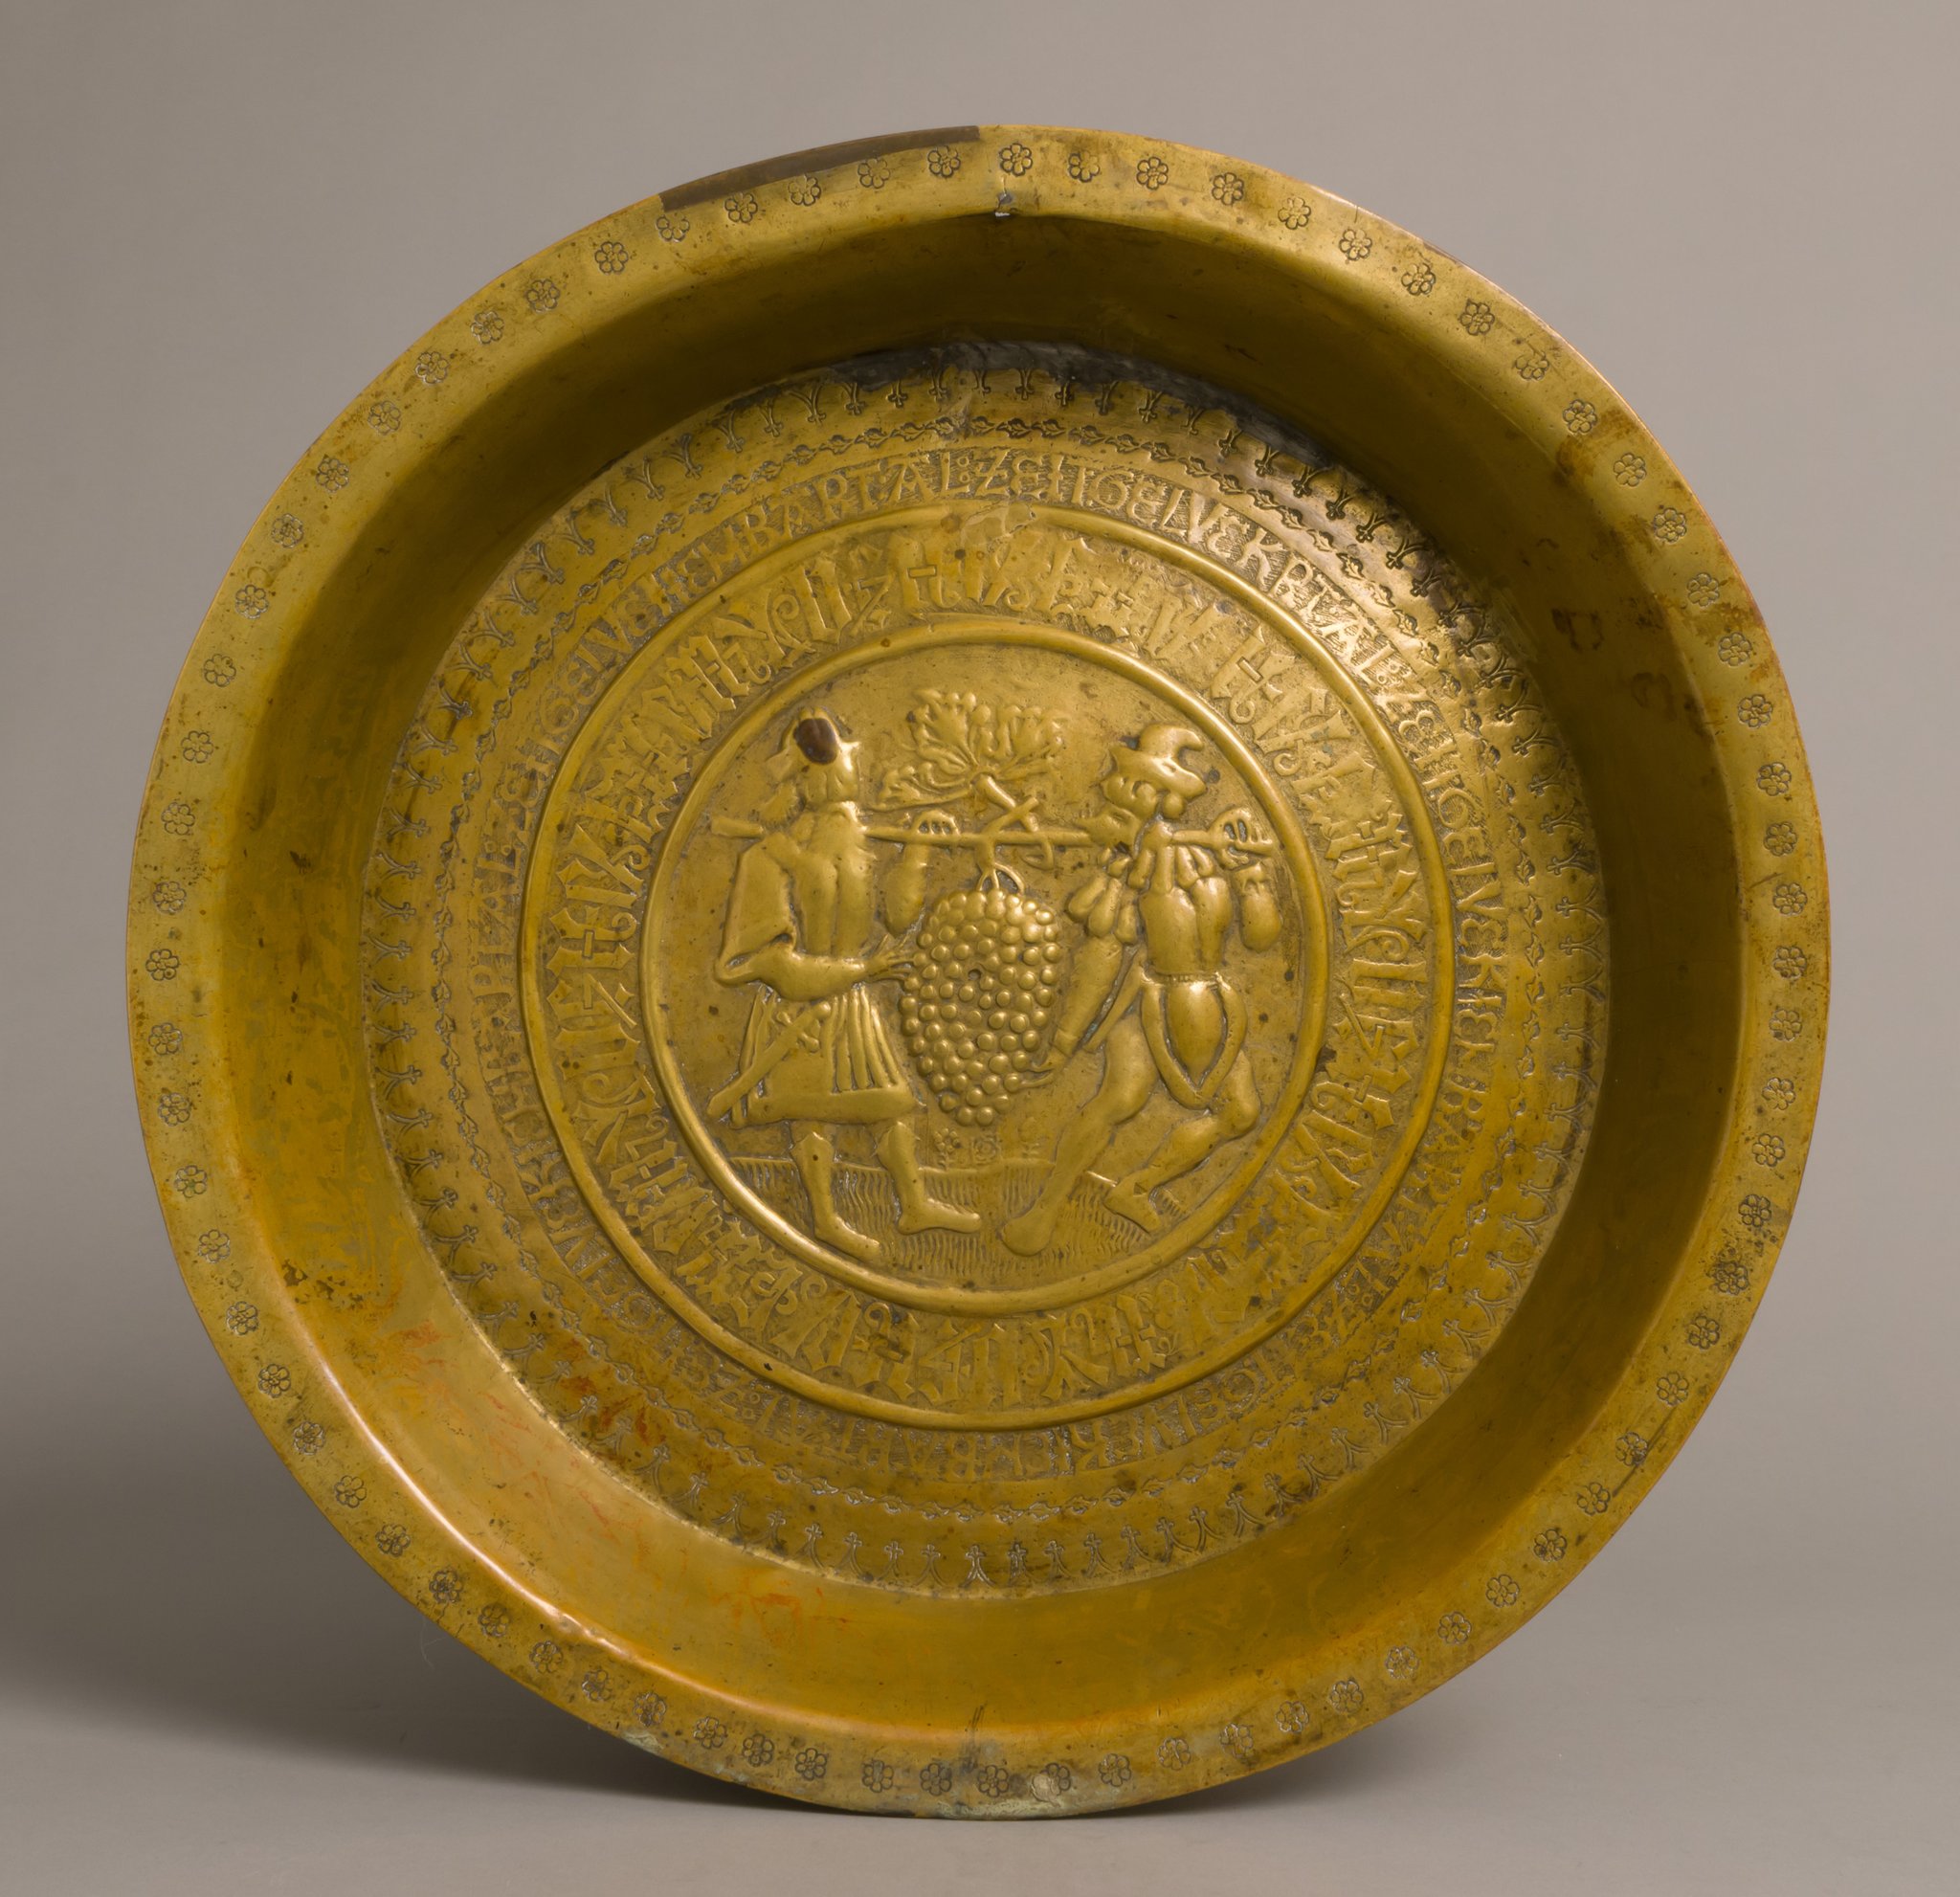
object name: plate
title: Plate, Joshua and Kaleb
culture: german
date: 1500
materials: brass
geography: germany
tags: grapes,men